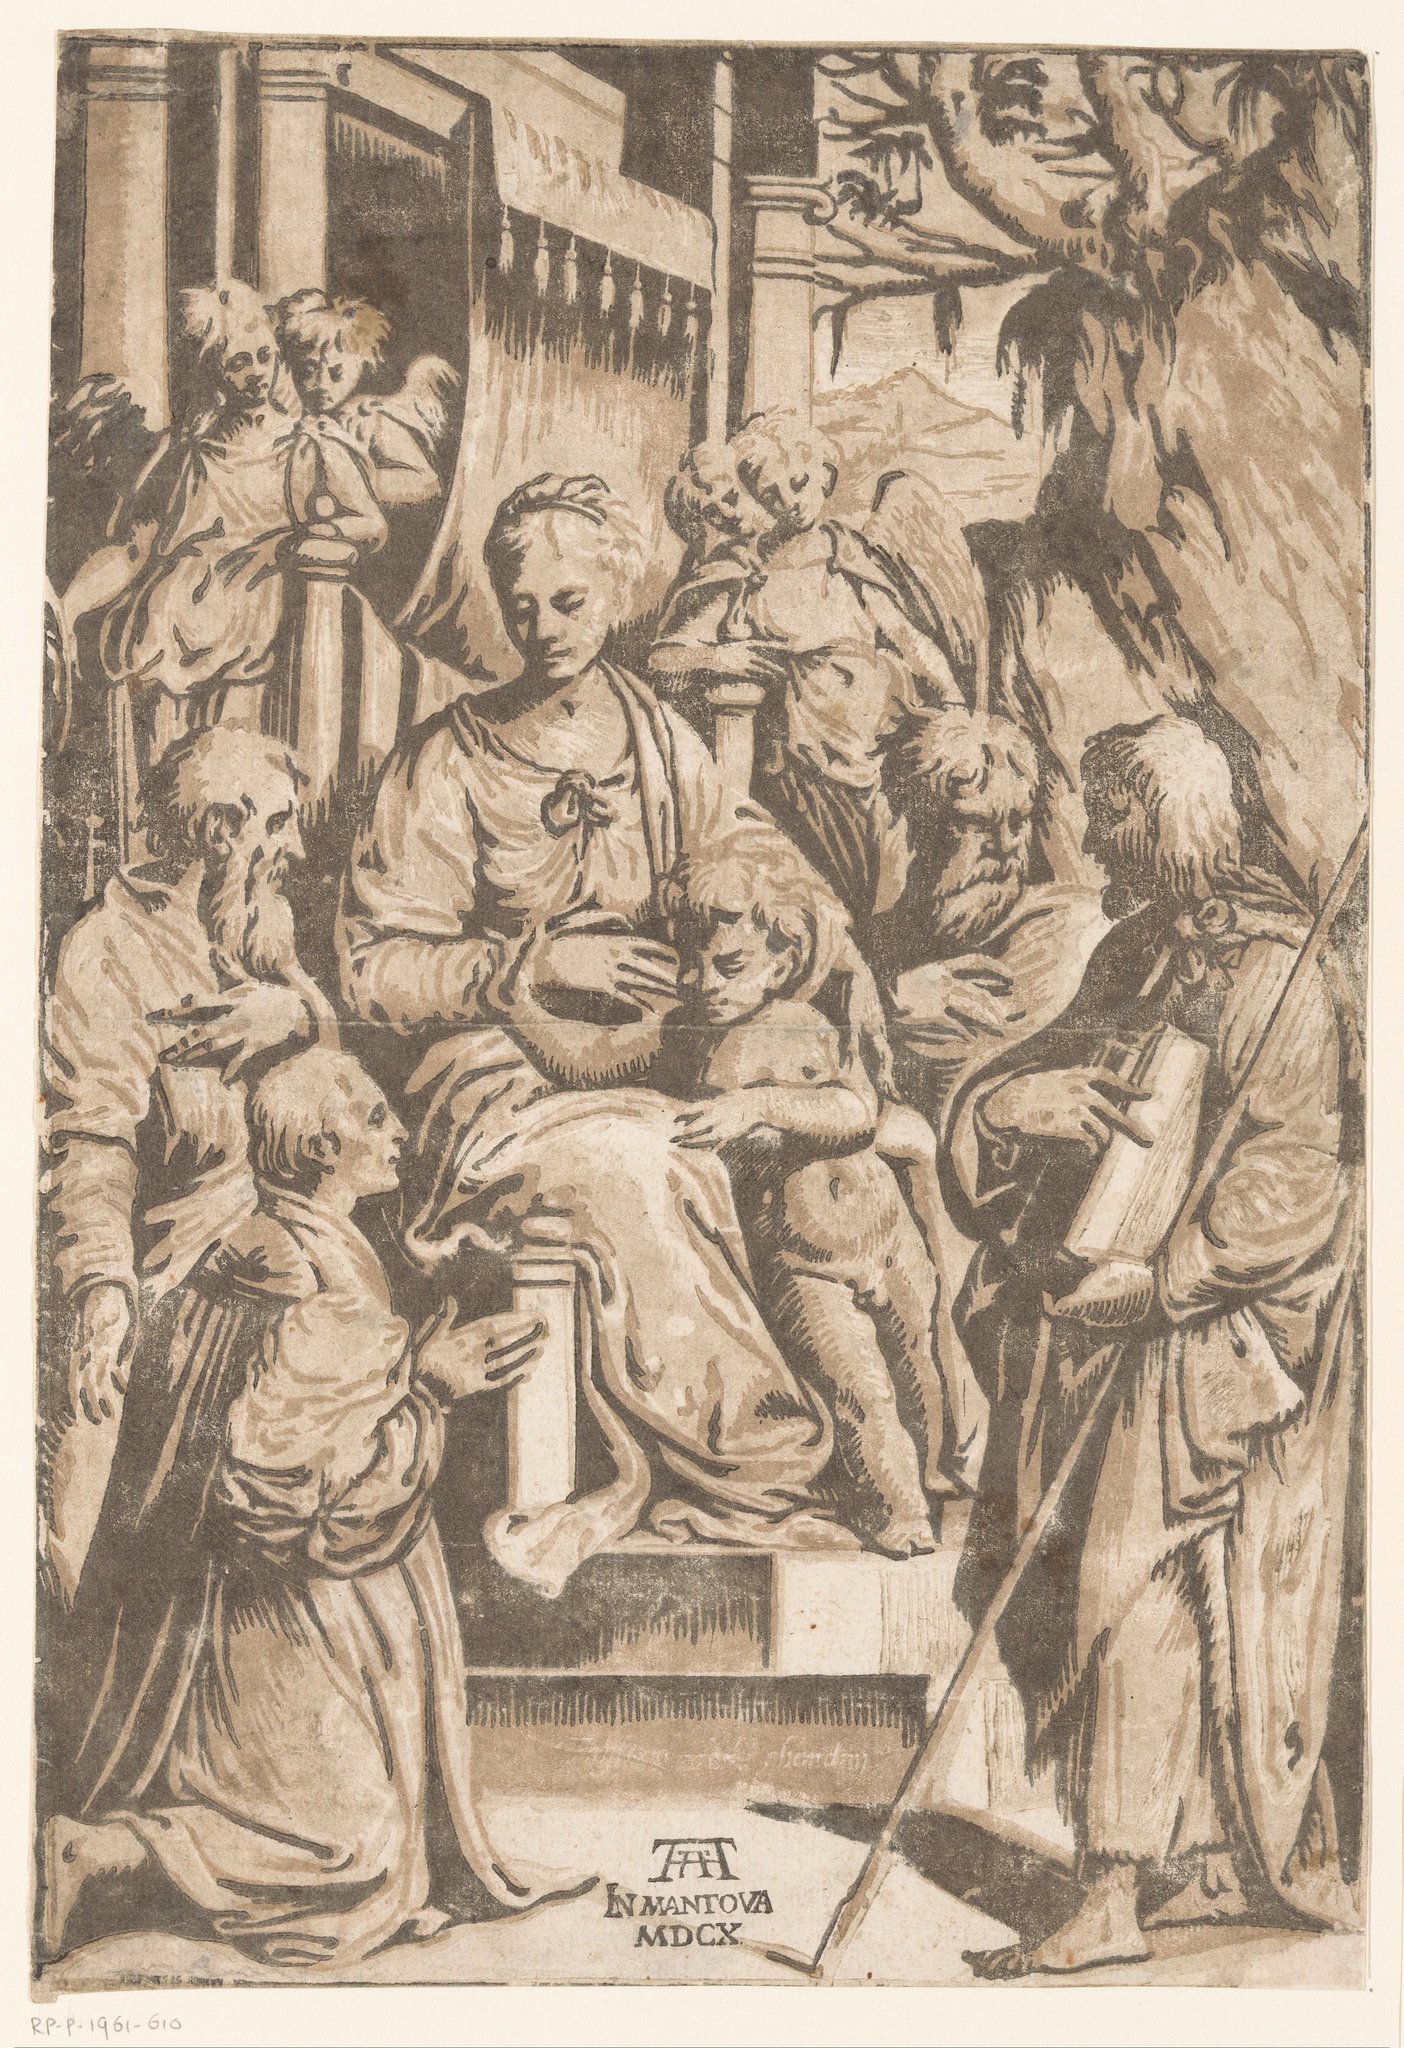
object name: print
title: Maria met kind omringd door heiligen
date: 1610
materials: paper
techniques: woodcut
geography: bologna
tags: john the baptist; possible attributes: book, reed cross, baptismal cup, honeycomb, lamb, staff, mary (standing) with the christ-child beside her (free-standing or leaning against her) - ff - mary sitting or enthroned, madonna accompanied by saint(s) (+ donor(s), supplicant(s), whether or not with patron saint(s)), angel(s) represented as youth(s) or adult(s)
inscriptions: collector's mark: Lugt 2228, collector's mark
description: Maria zit in het midden met naast haar het staande Christuskind. Zij worden door heiligen en engelen omringd. Rechts op de voorgrond staat de heilige Johannes de Doper.